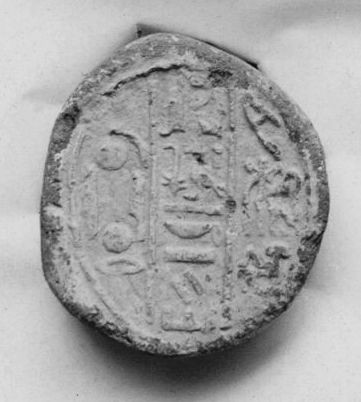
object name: cone, circular impression, merymose, king's son, kush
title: Funerary Cone of the King's Son of Kush Merymose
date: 1550-1295 BCE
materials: pottery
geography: egypt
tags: hieroglyphs